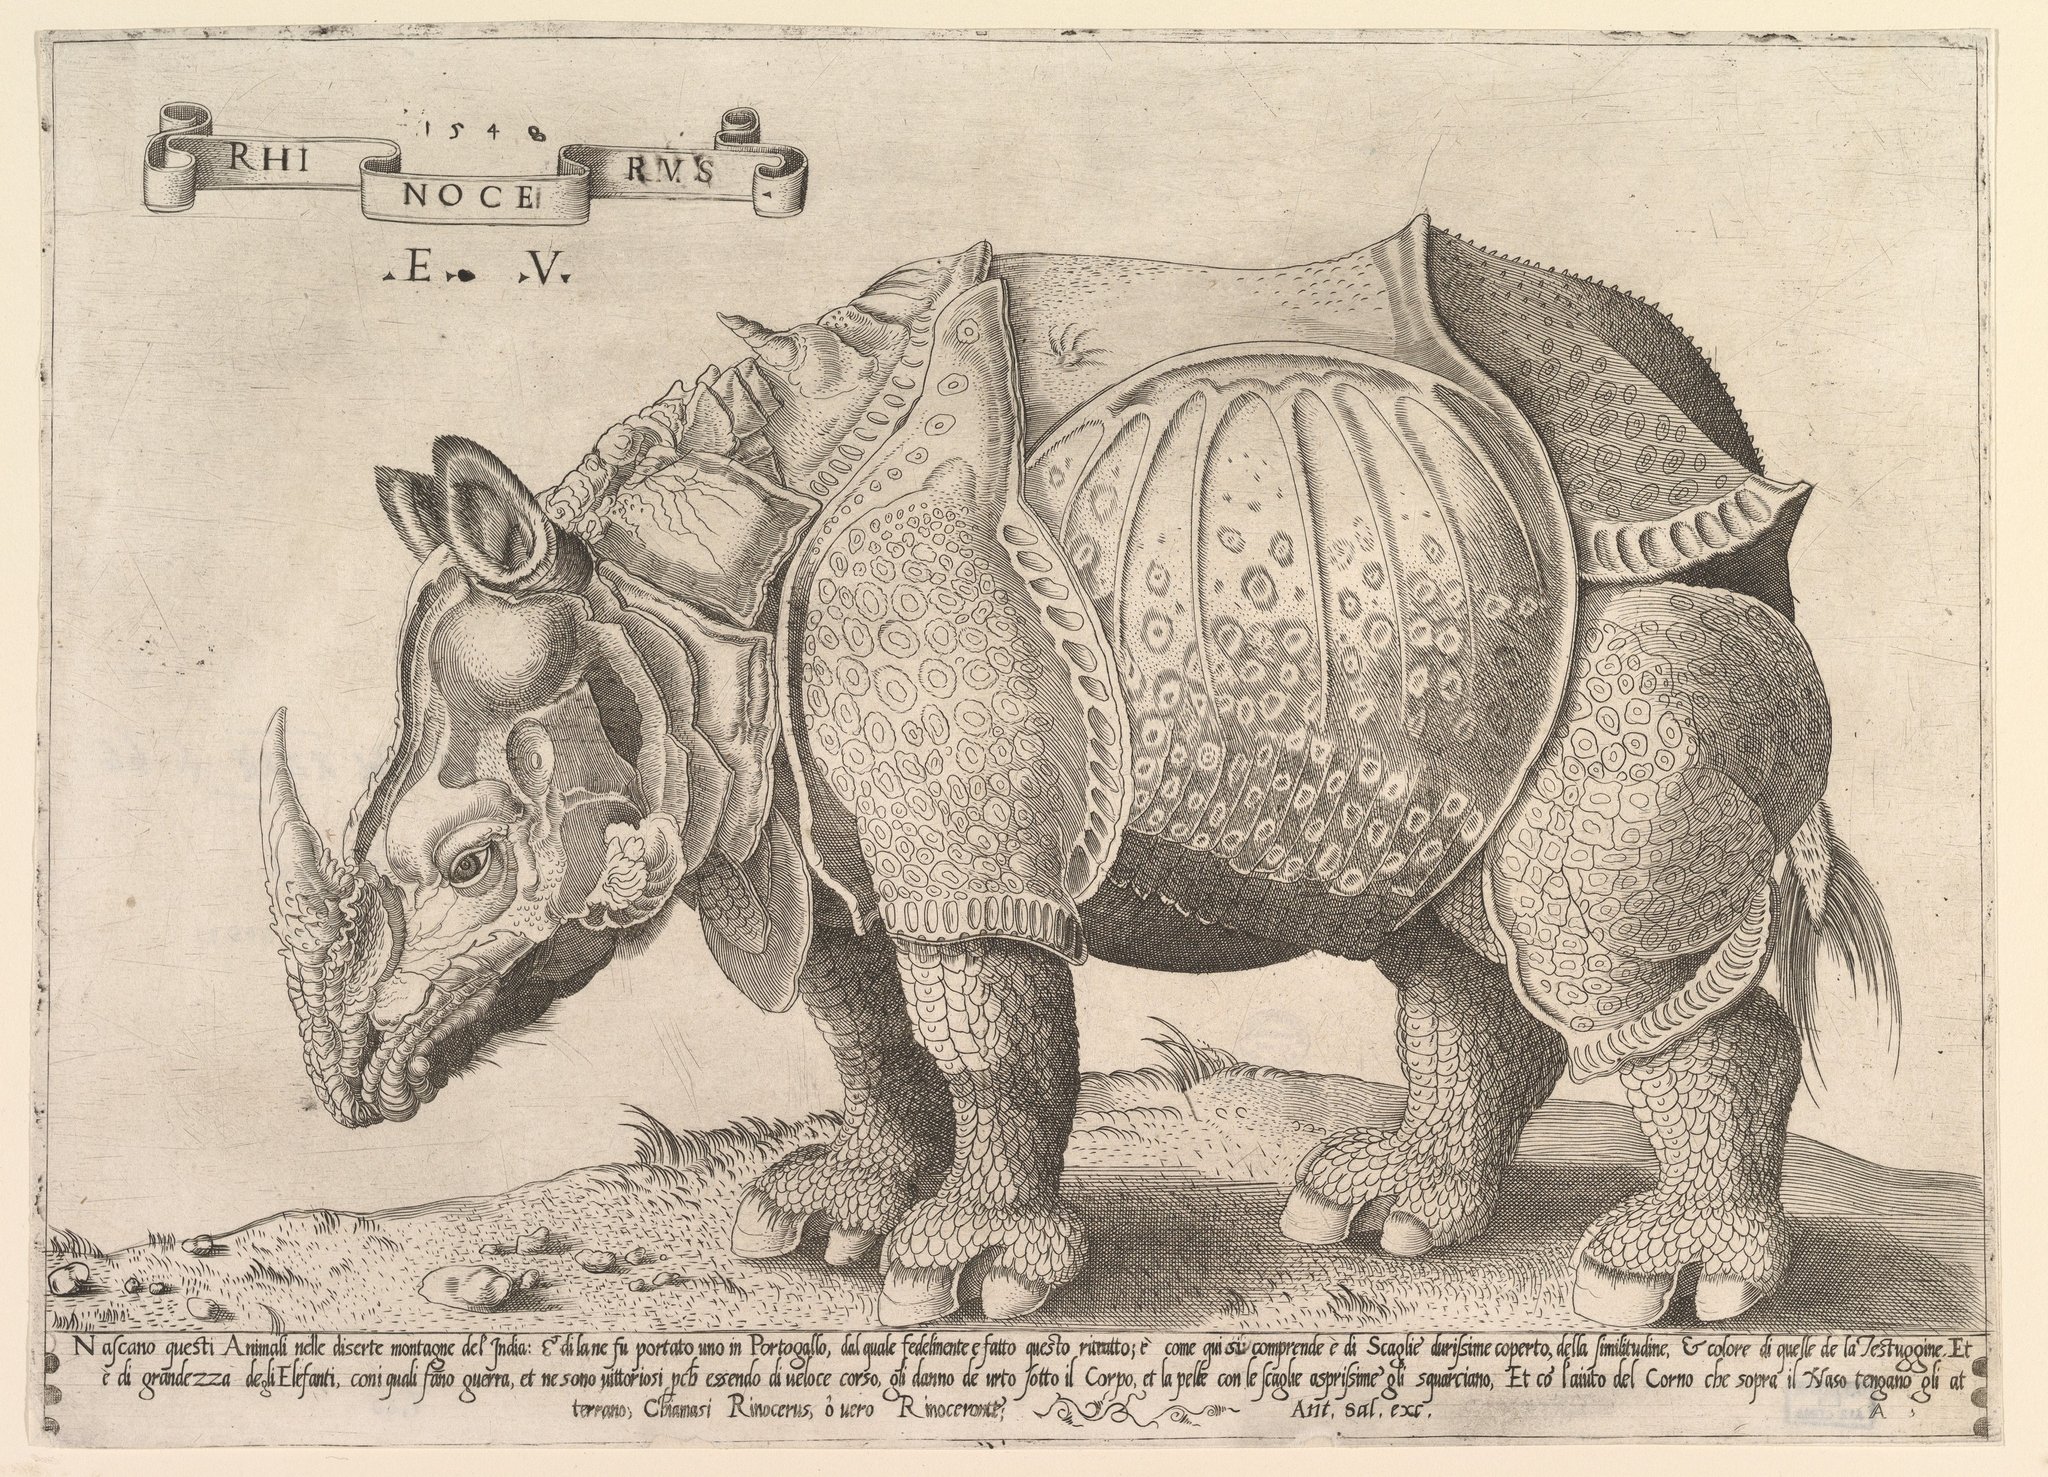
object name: print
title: Rhinoceros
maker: enea vico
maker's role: artist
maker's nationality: italian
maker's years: 1523-1567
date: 1542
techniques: engraving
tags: rhinoceros